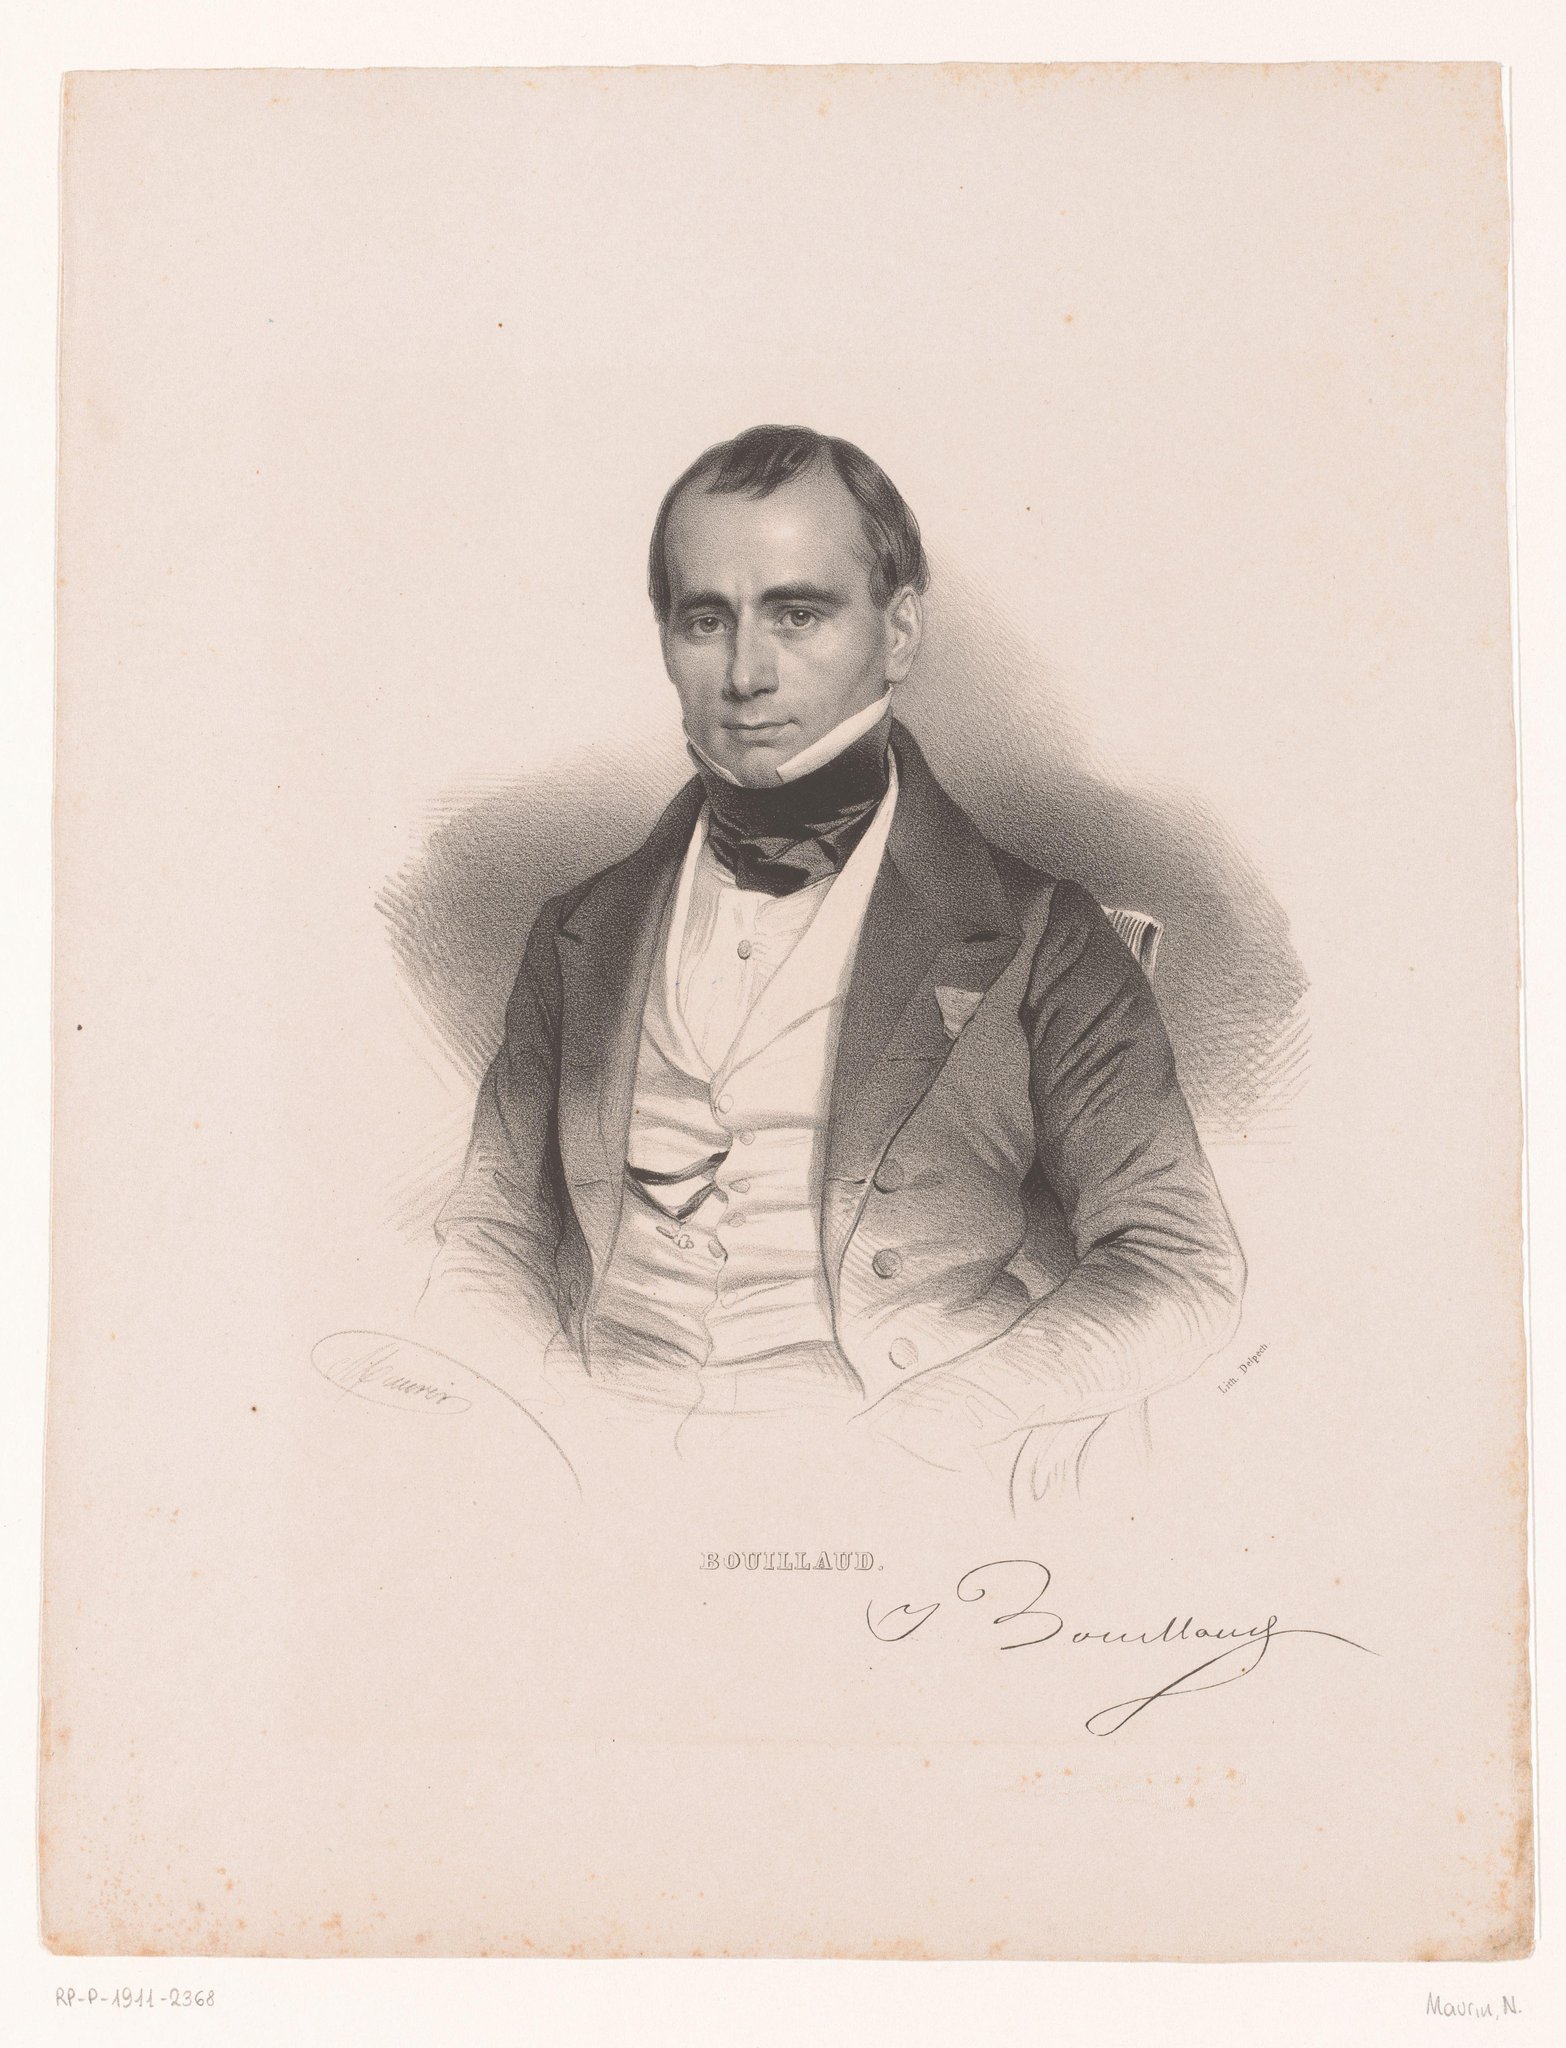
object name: print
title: Bouillaud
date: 1838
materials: paper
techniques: lithograph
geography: paris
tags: paris, historical persons, physician, doctor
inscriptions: collector's mark: Lugt 2228